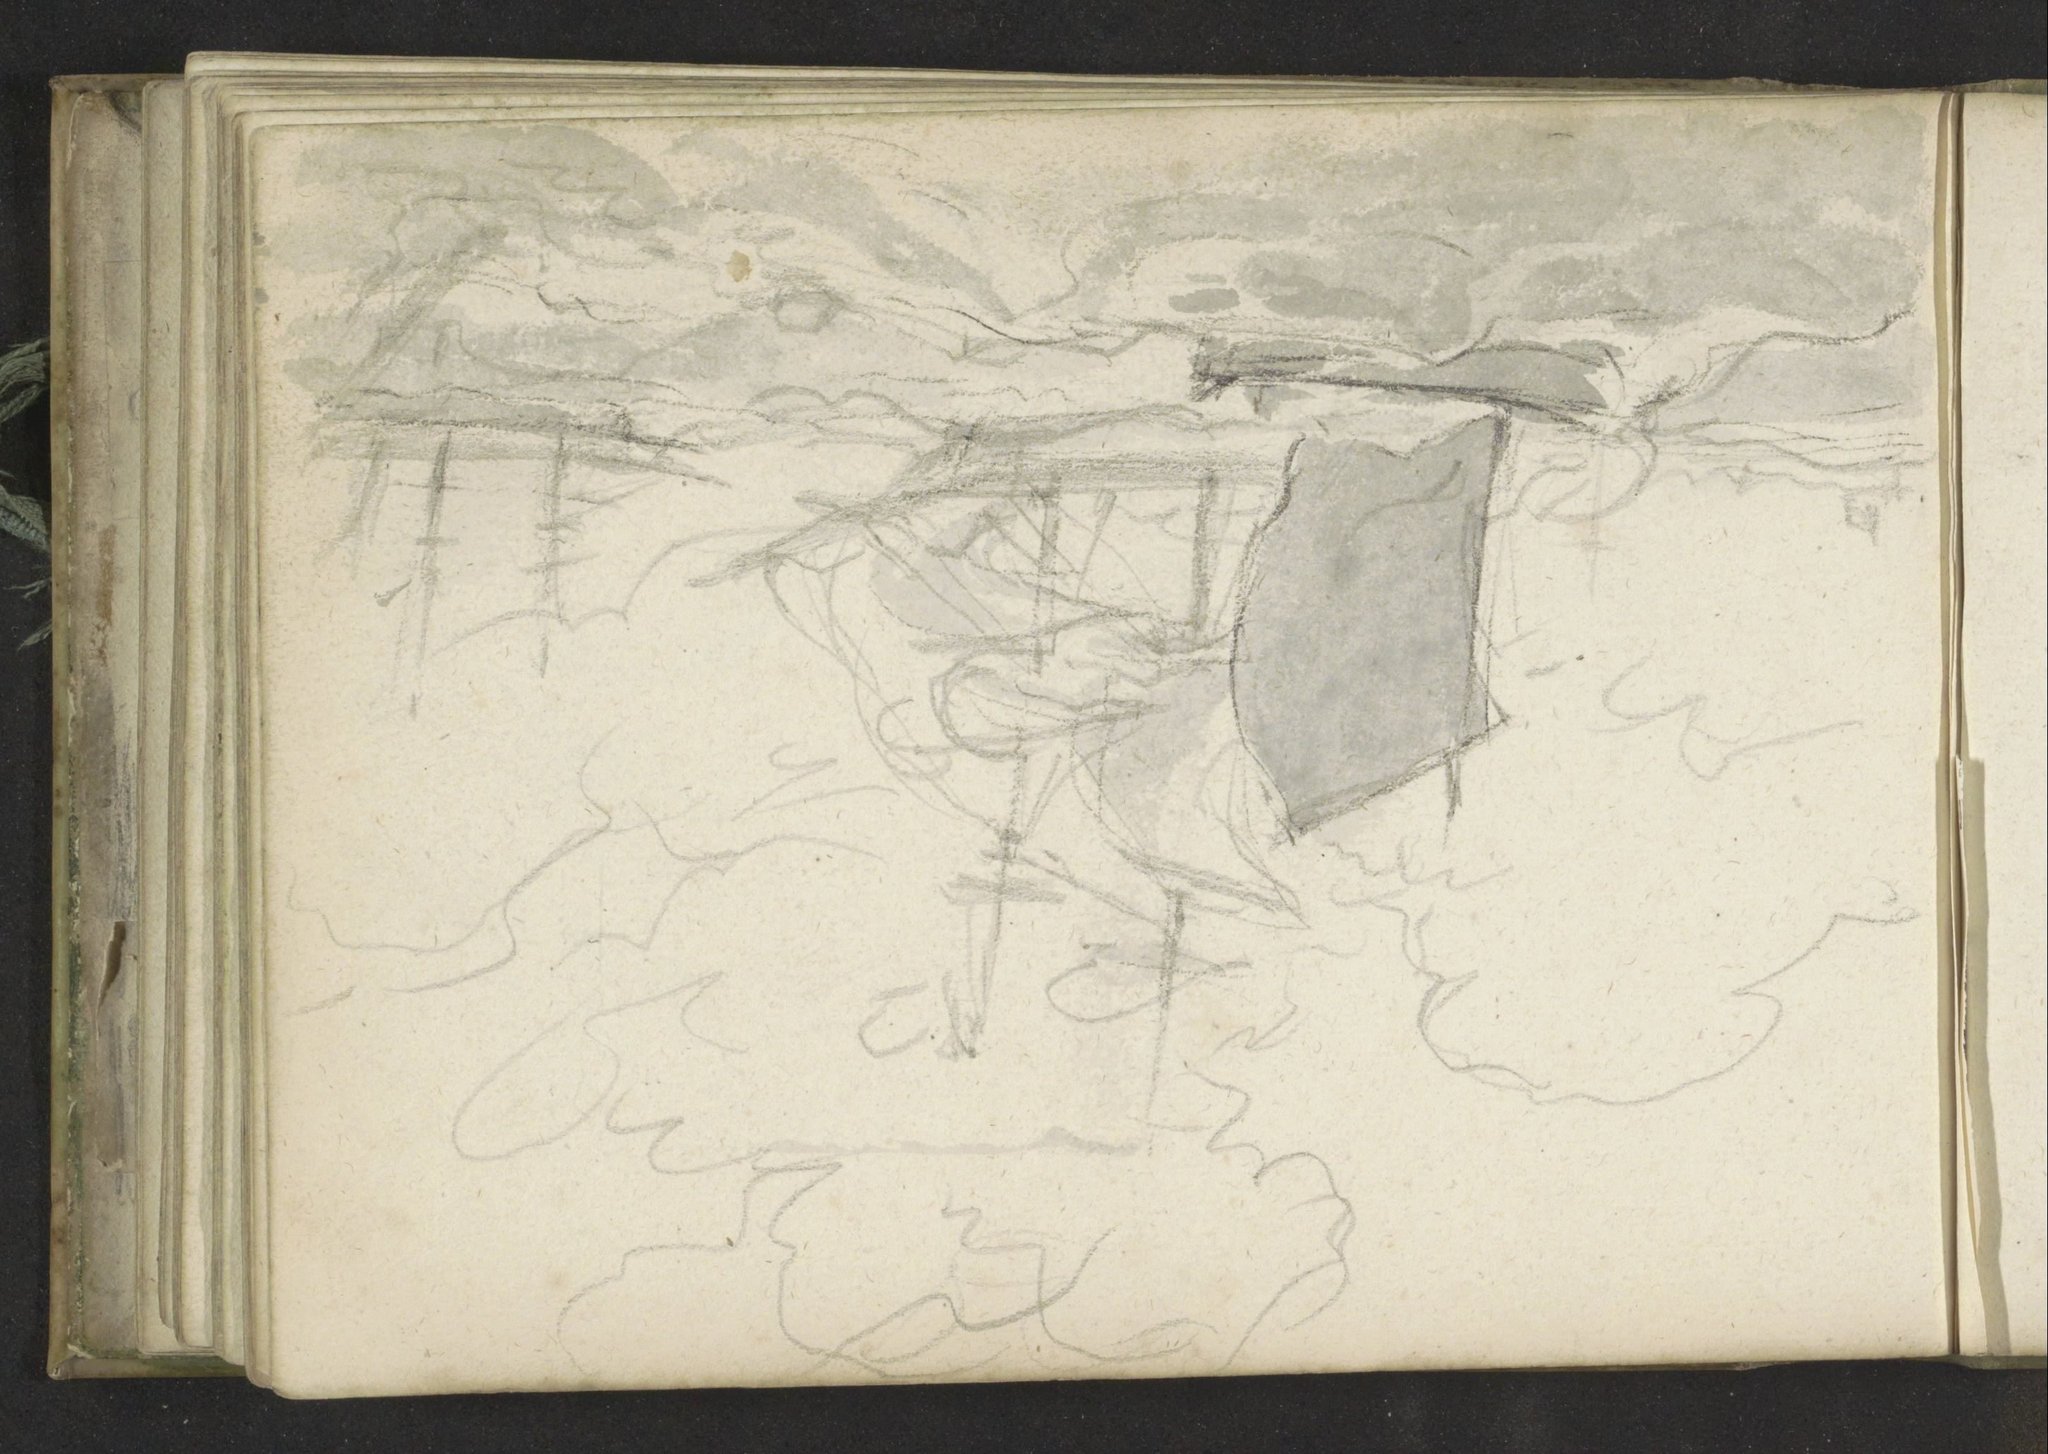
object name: sketchbook leaf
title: Zeilschepen op een woelige zee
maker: martinus schouman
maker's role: draughtsman, painter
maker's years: 1770-1848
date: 1780-1848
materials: chalk, paper, pencil, watercolor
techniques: brush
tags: sailing-ship, sailing-boat, storm at sea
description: Blad 51 verso uit een schetsboek met 53 bladen.